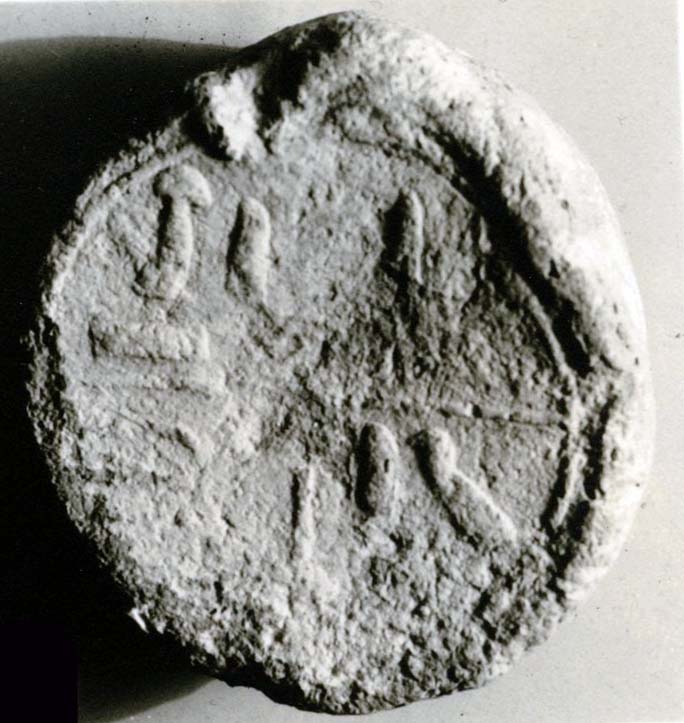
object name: cone, amenhotep, doorkeeper, amun, rebiu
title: Funerary Cone of the Doorkeeper of Amun Amenhotep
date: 1550-1295 BCE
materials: pottery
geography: egypt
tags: hieroglyphs